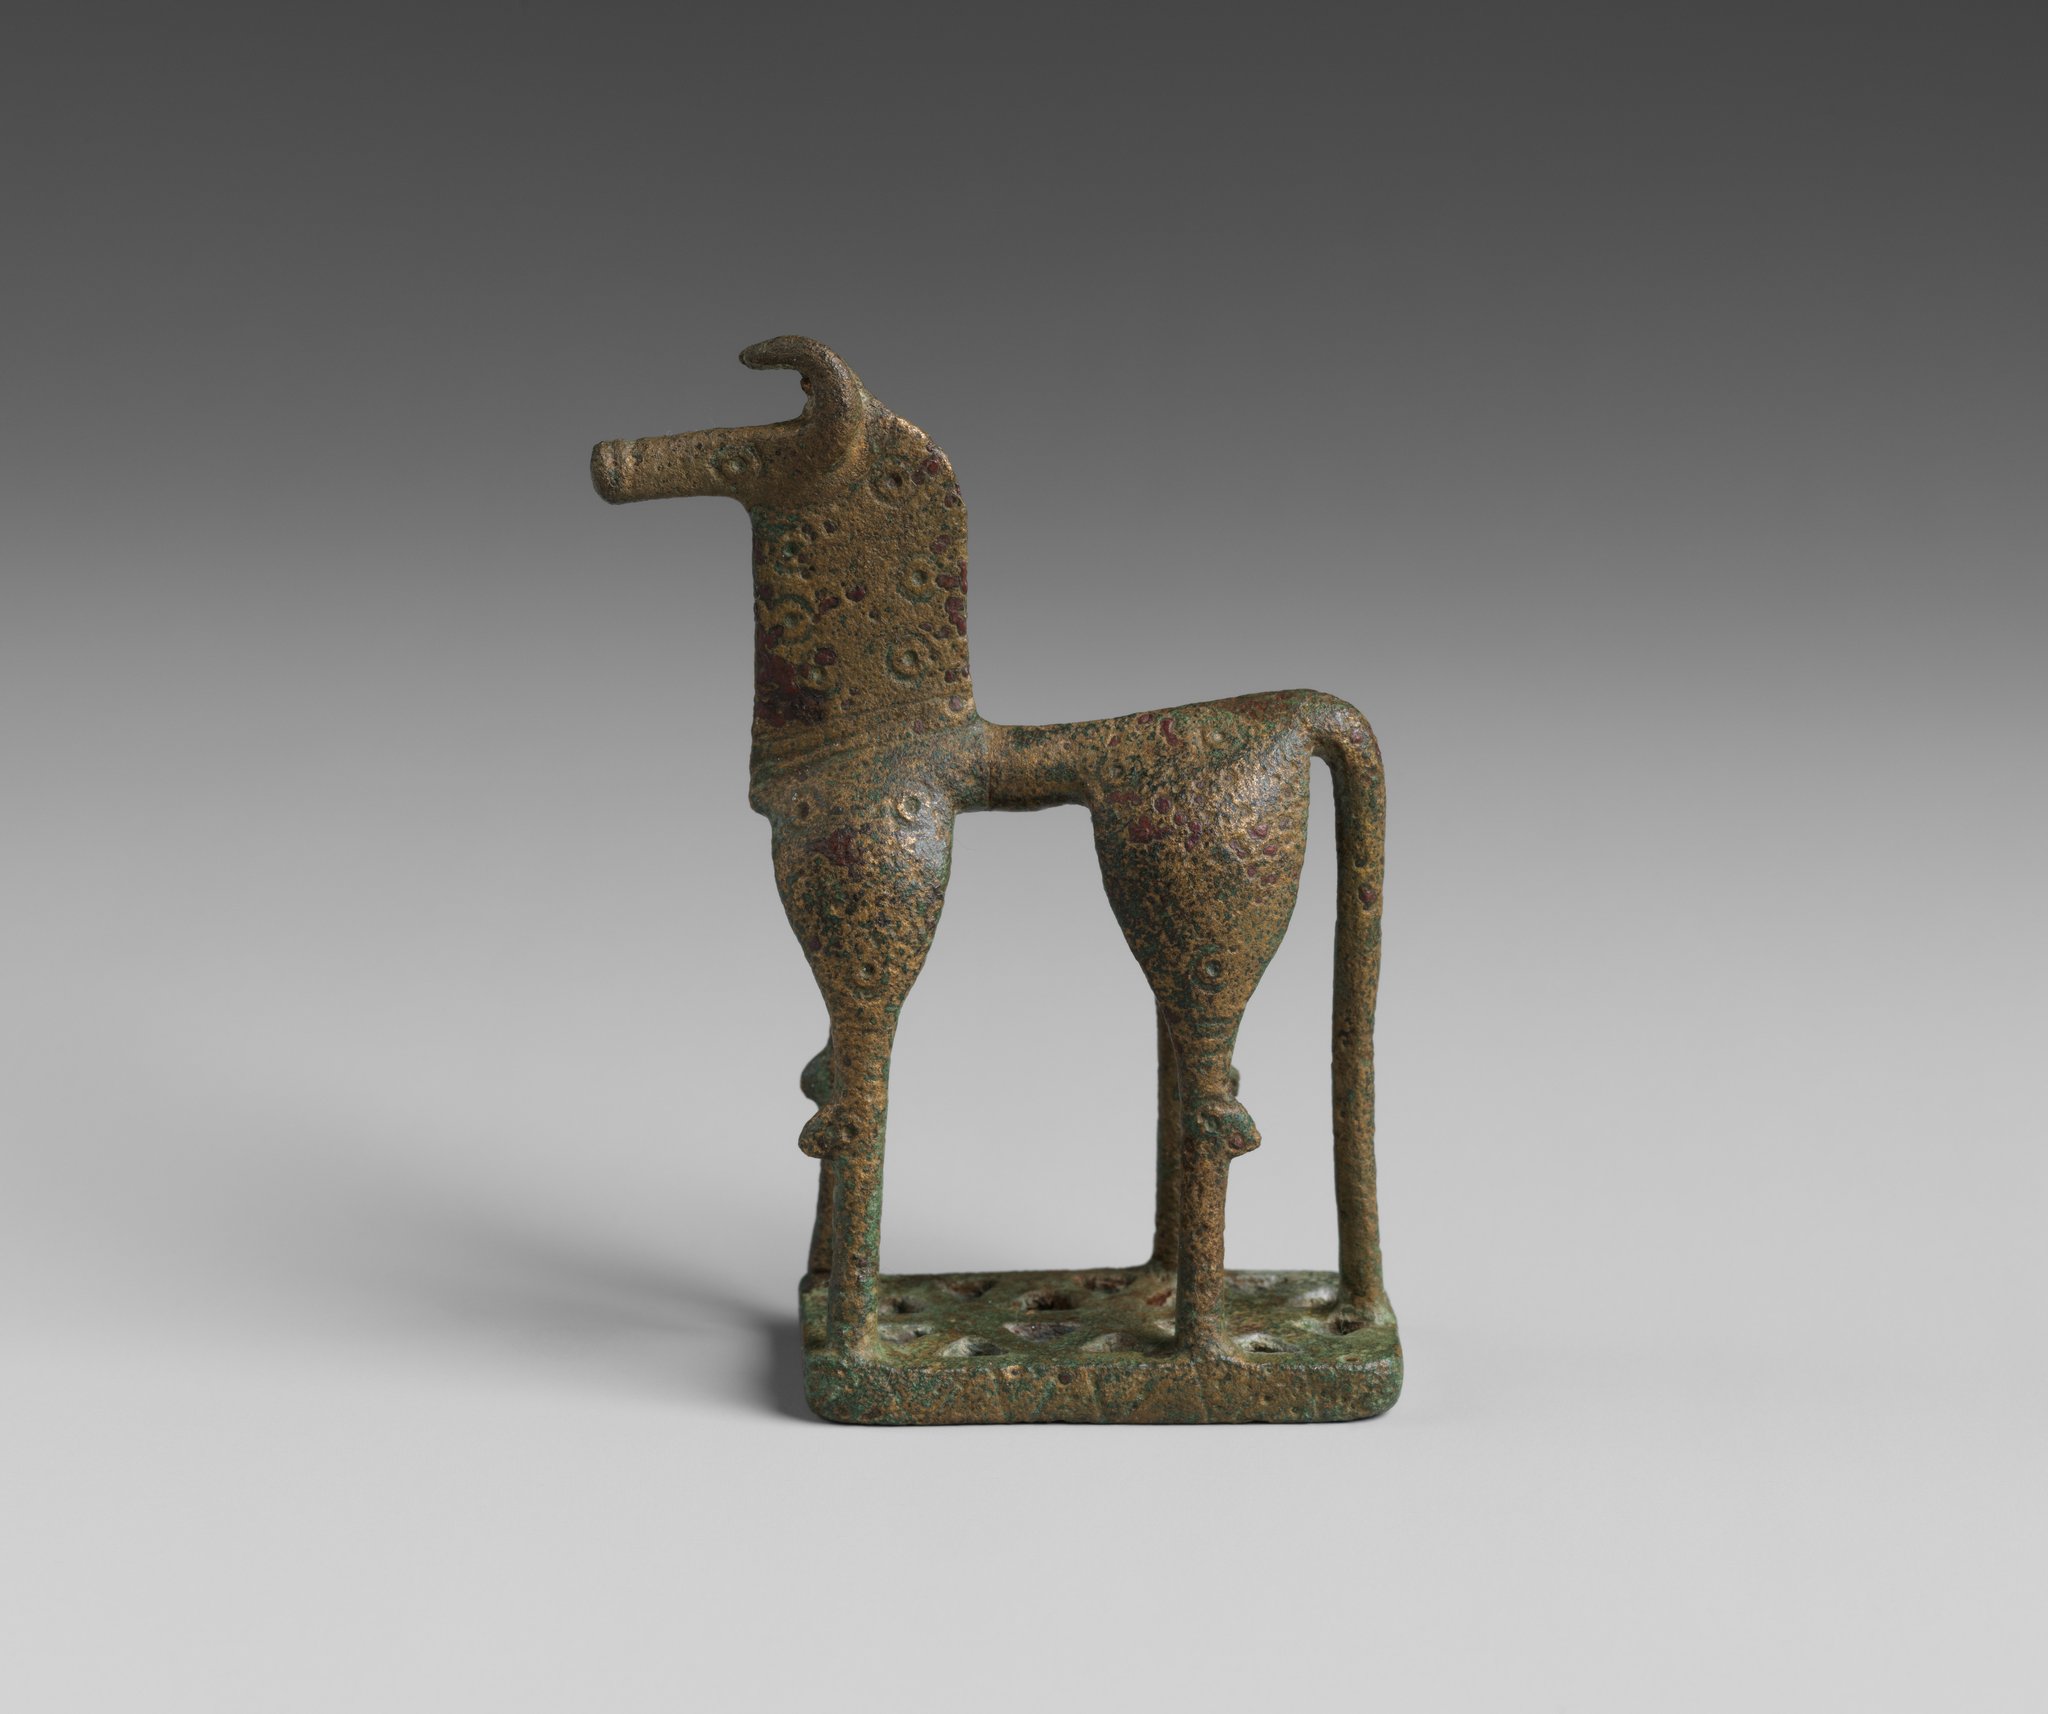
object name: statuette of a horse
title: Bronze horse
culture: greek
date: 767-735 BCE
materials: bronze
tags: horses